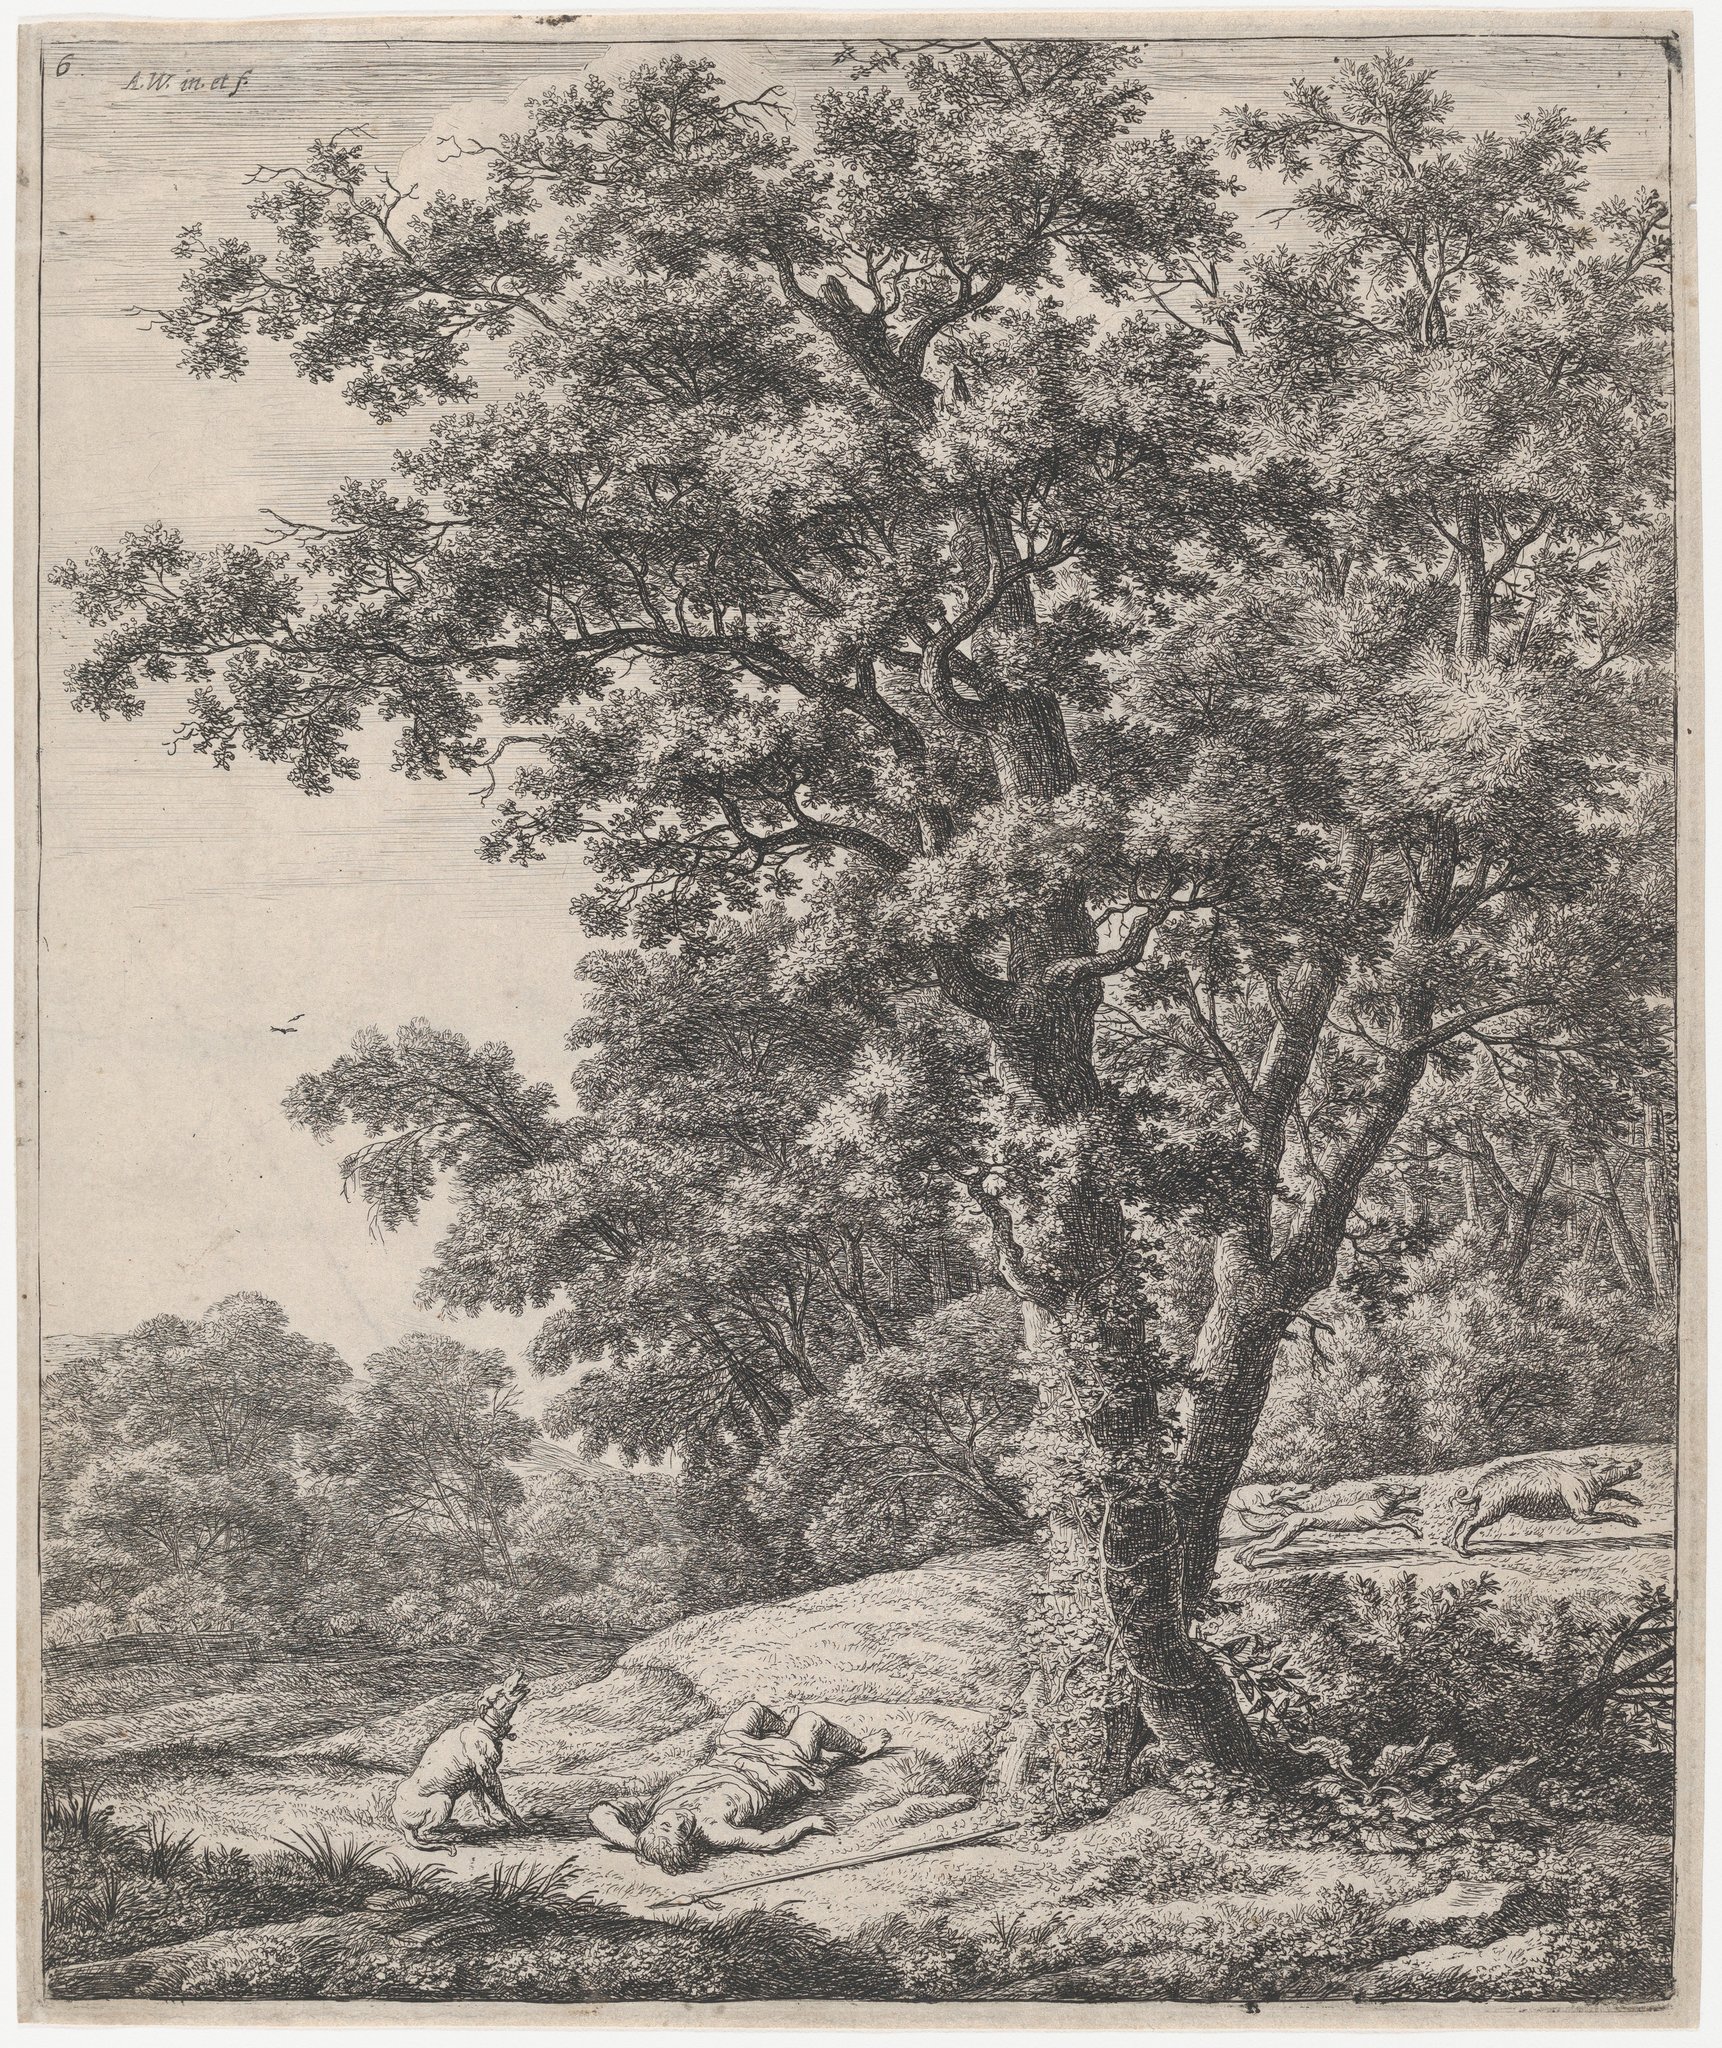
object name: print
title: The Death of Adonis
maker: anthonie waterloo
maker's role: artist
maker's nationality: dutch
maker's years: 1609-1690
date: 1601-1700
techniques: etching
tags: birds,adonis,dogs,trees,death